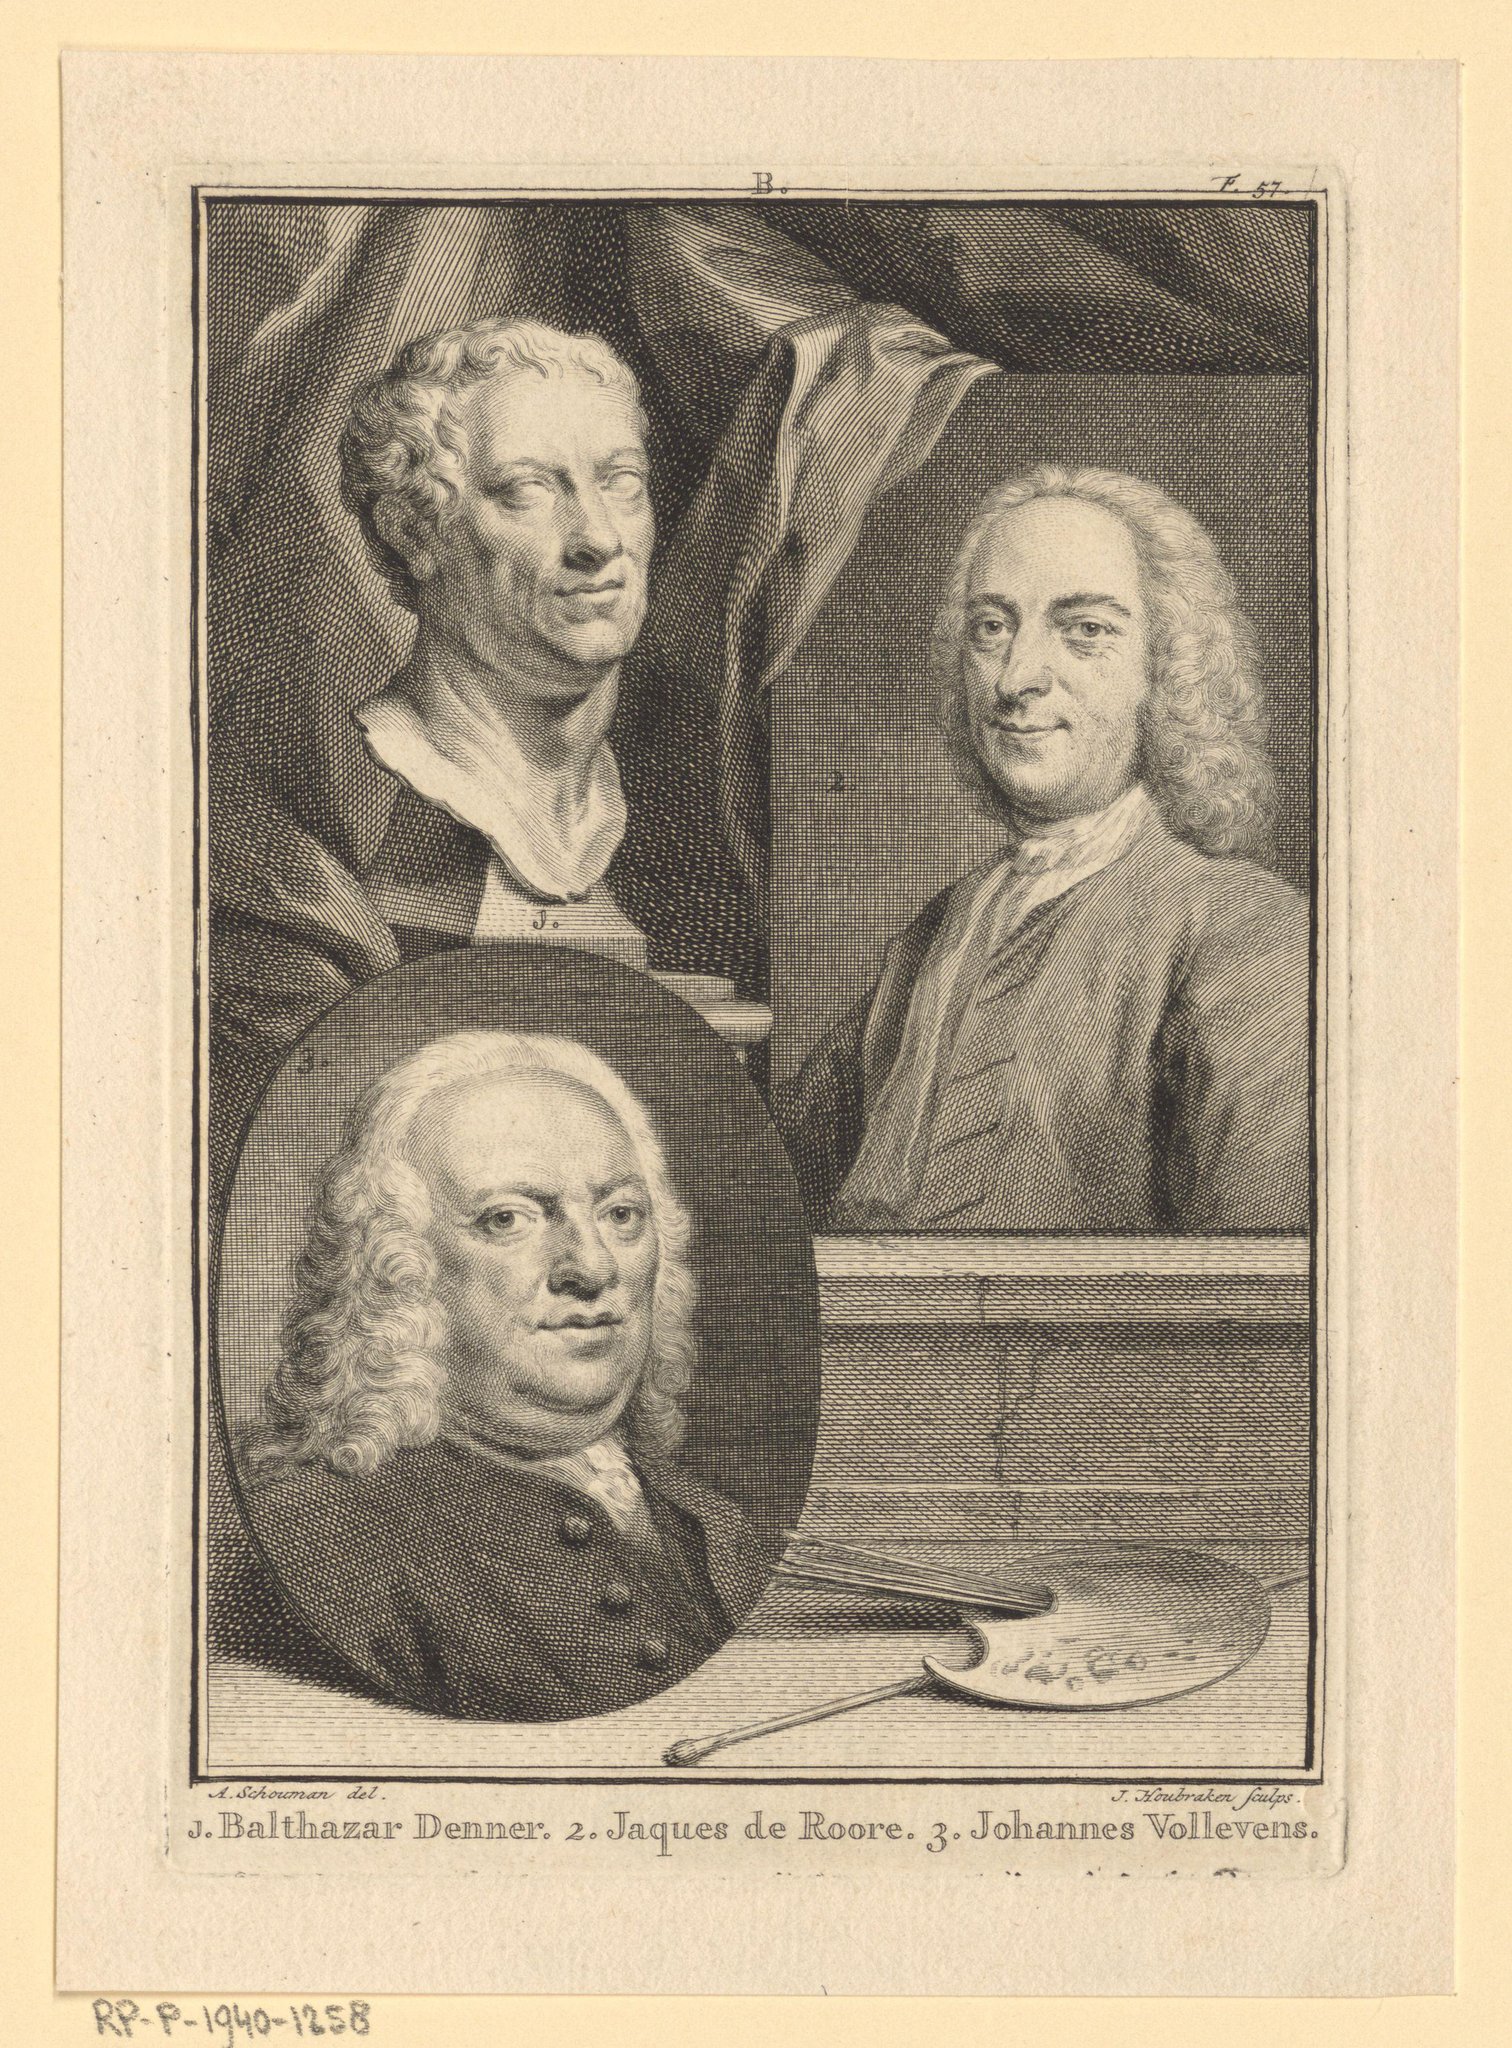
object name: print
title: Portretten van Balthasar Denner, Jacques Ignatius de Roore en Johannes Vollevens II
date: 1751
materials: paper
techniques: engraving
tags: print maker, balthasar denner, antwerp, the hague, painter, jacques ignatius de roore, johannes vollevens (ii), historical persons, portrait, self-portrait of painter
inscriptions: collector's mark: Lugt 2760, collector's mark: Lugt 2228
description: Prent mogelijk uit: Gool, Johan van. De nieuwe Schouburg der Nederlantsche kunstschilders en schilderessen (...). Den Haag: Johan van Gool, 1751, dl. 2.